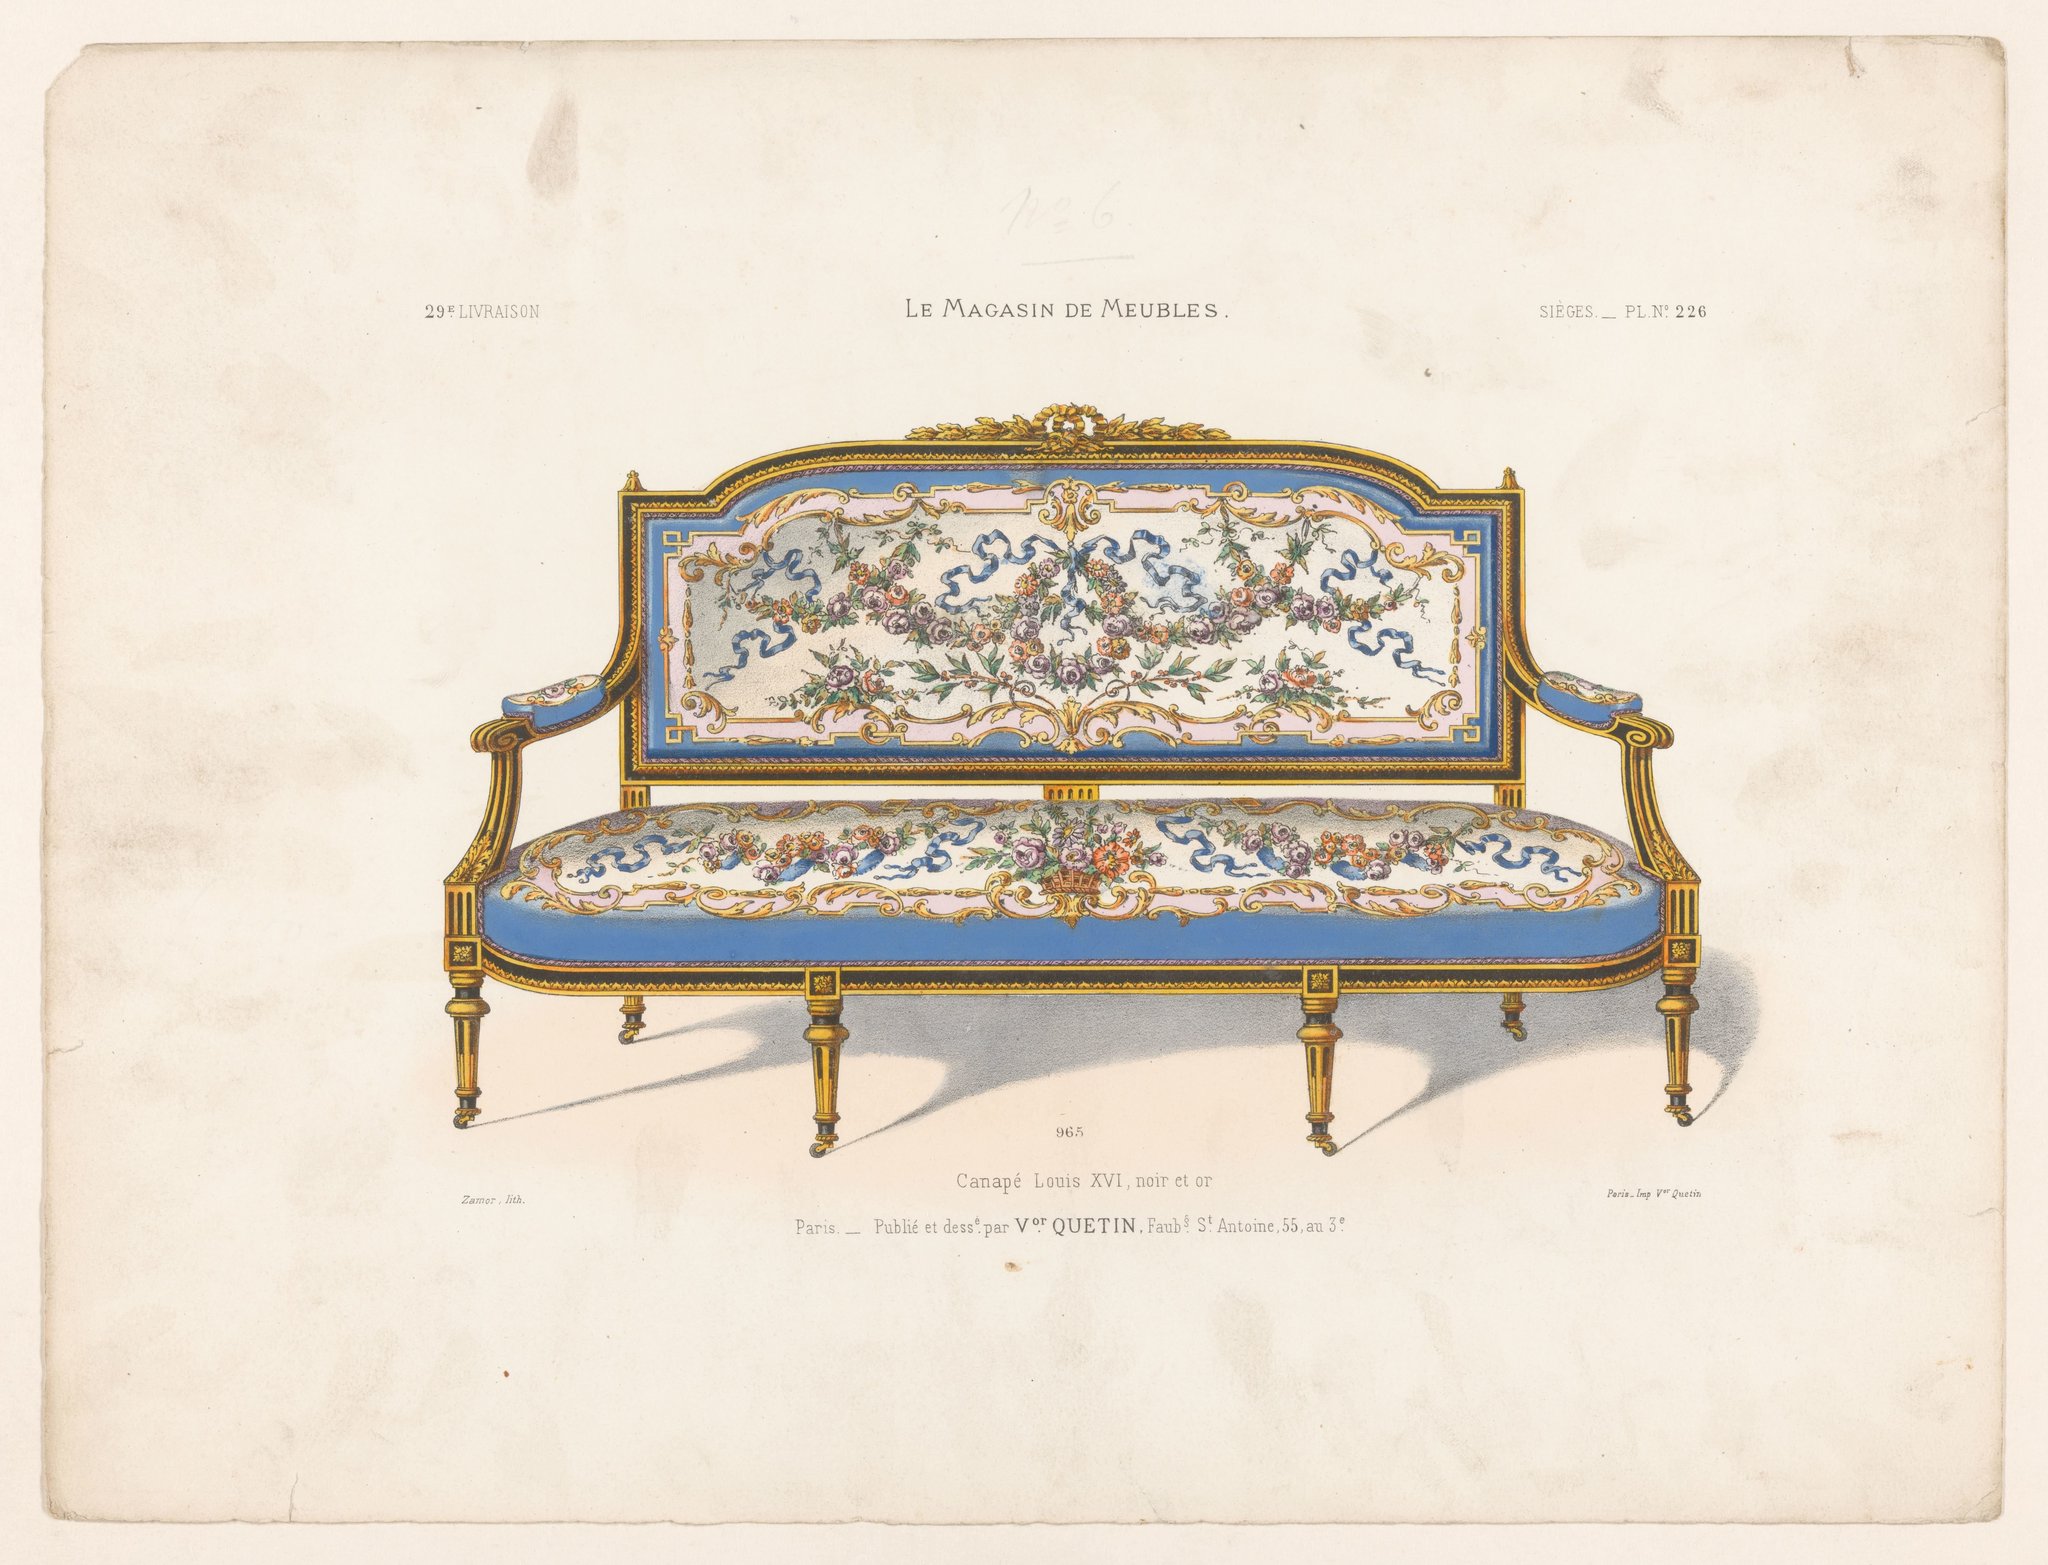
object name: print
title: Canapé Louis XVI, noir et or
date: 1832-1877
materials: paper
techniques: hand coloring, lithograph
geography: paris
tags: seating furniture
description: Een canapé in de Lodewijk XVI-stijl. Prent uit 29e Livraison.